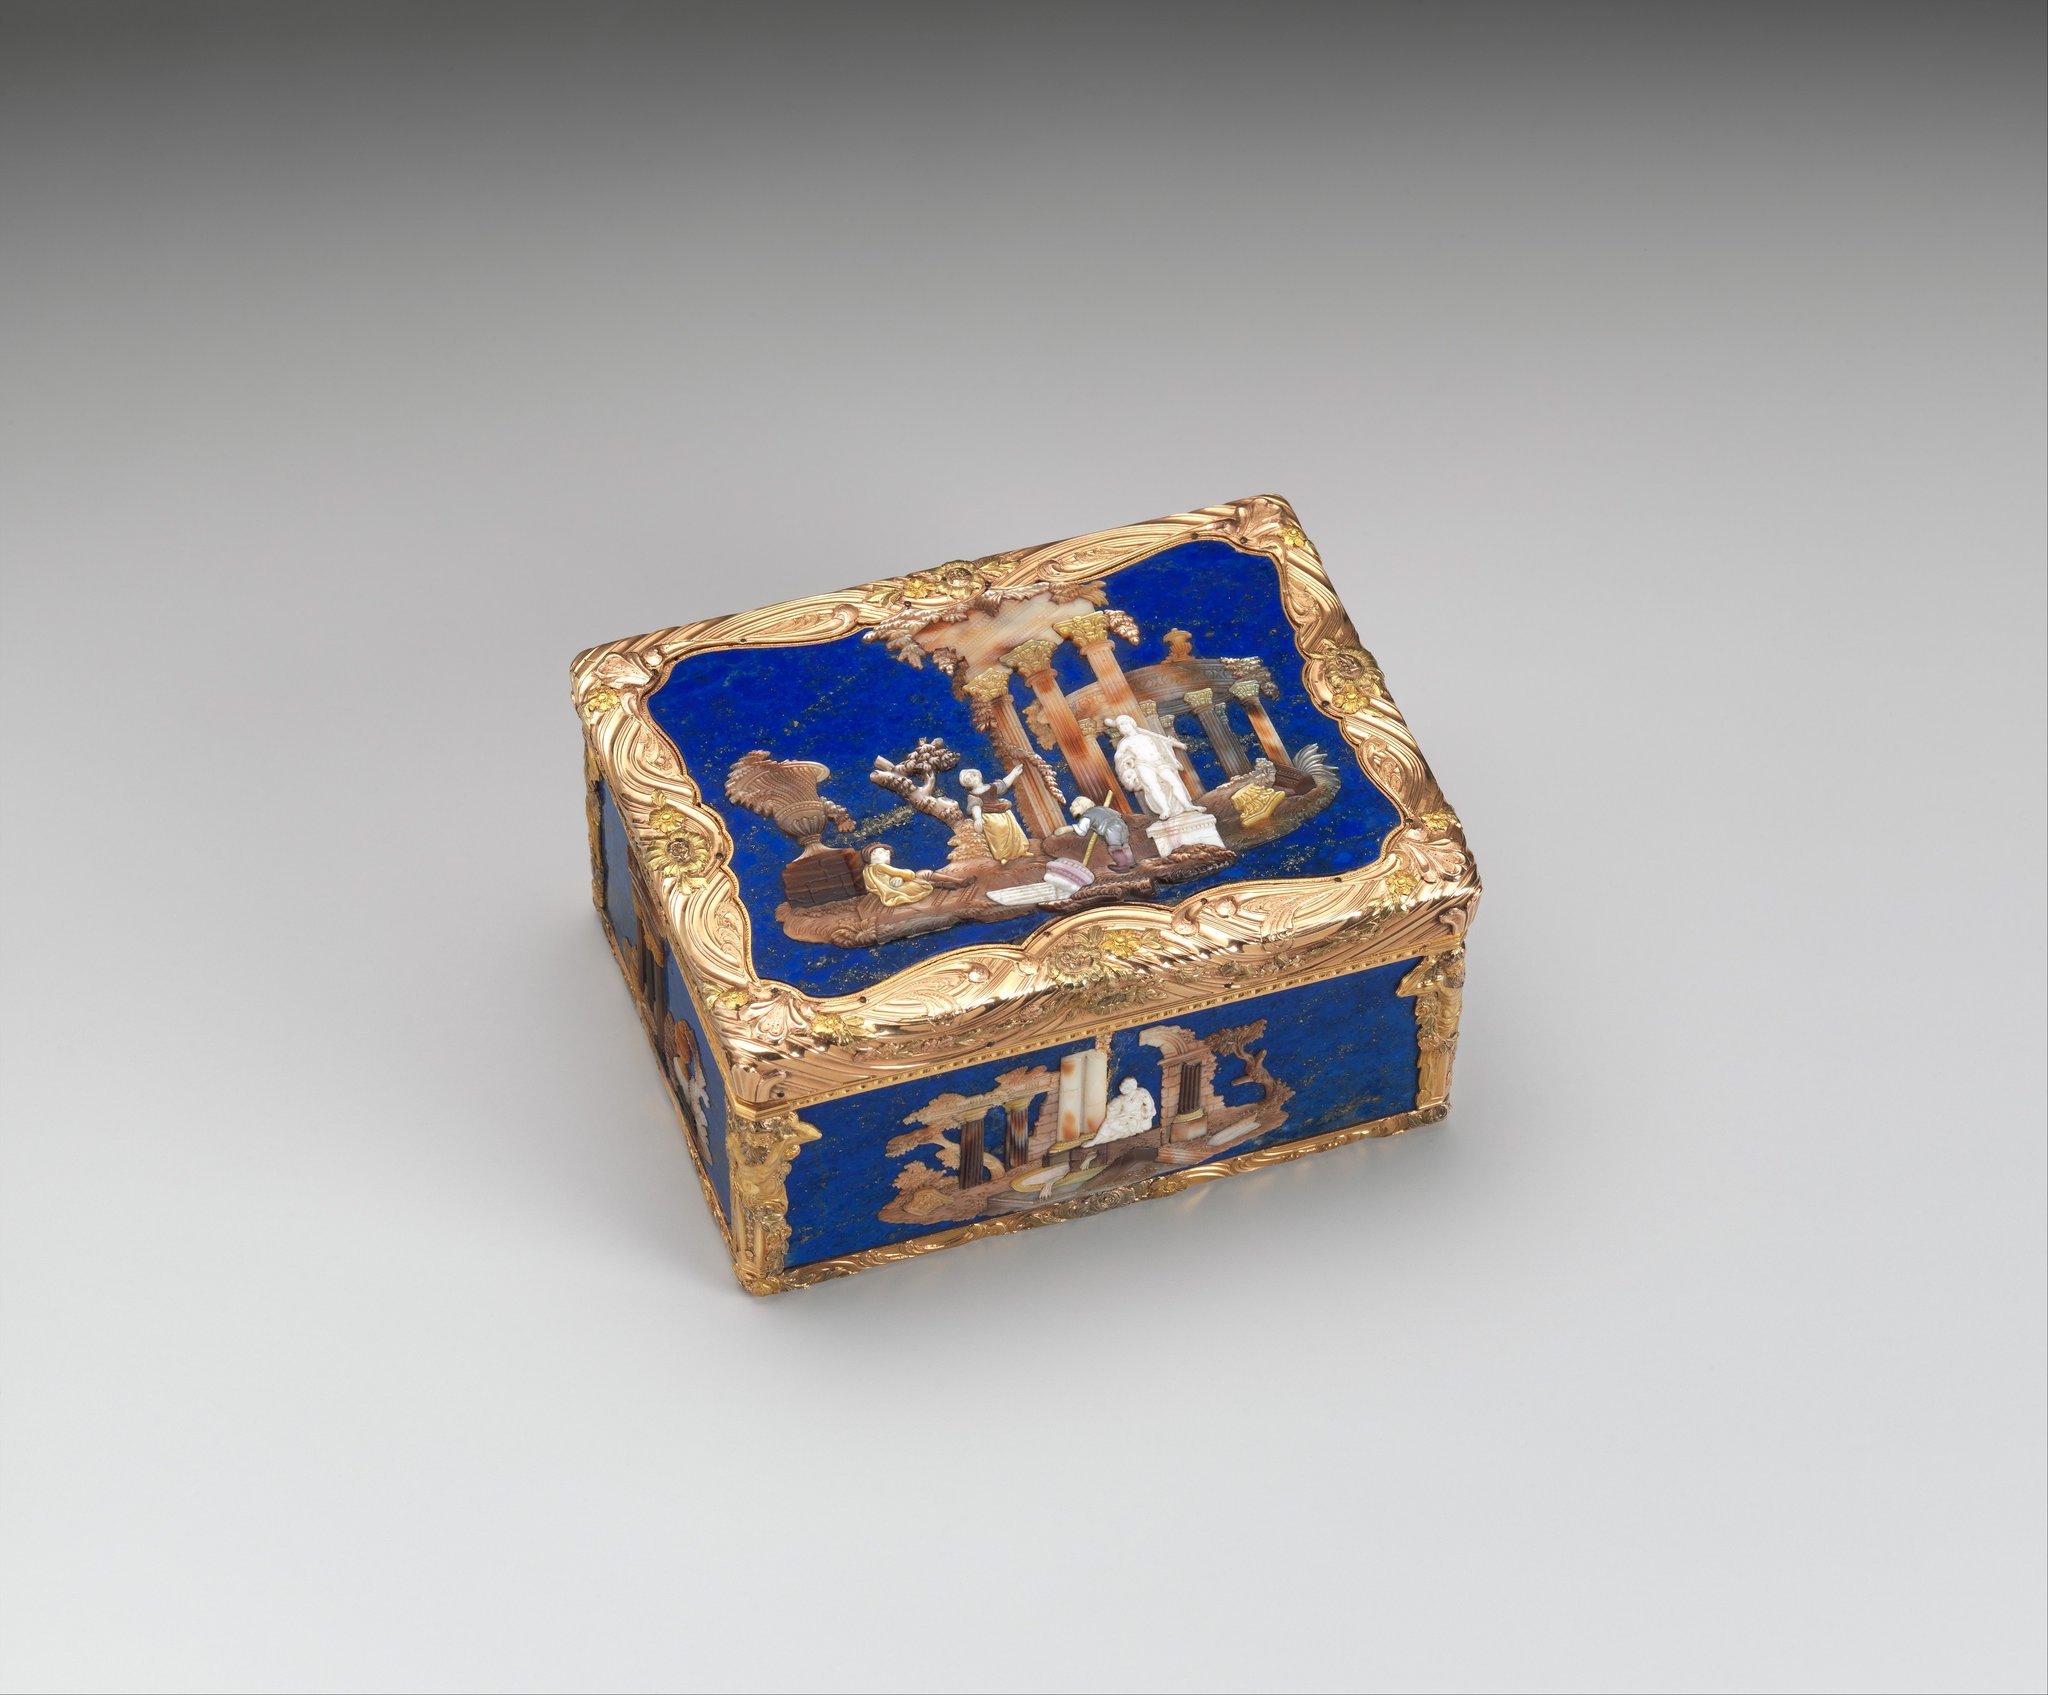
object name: snuffbox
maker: d. b., stettin, germany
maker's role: maker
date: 1765-1770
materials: gold, ivory, lapis lazuli, mother of pearl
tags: human figures,columns